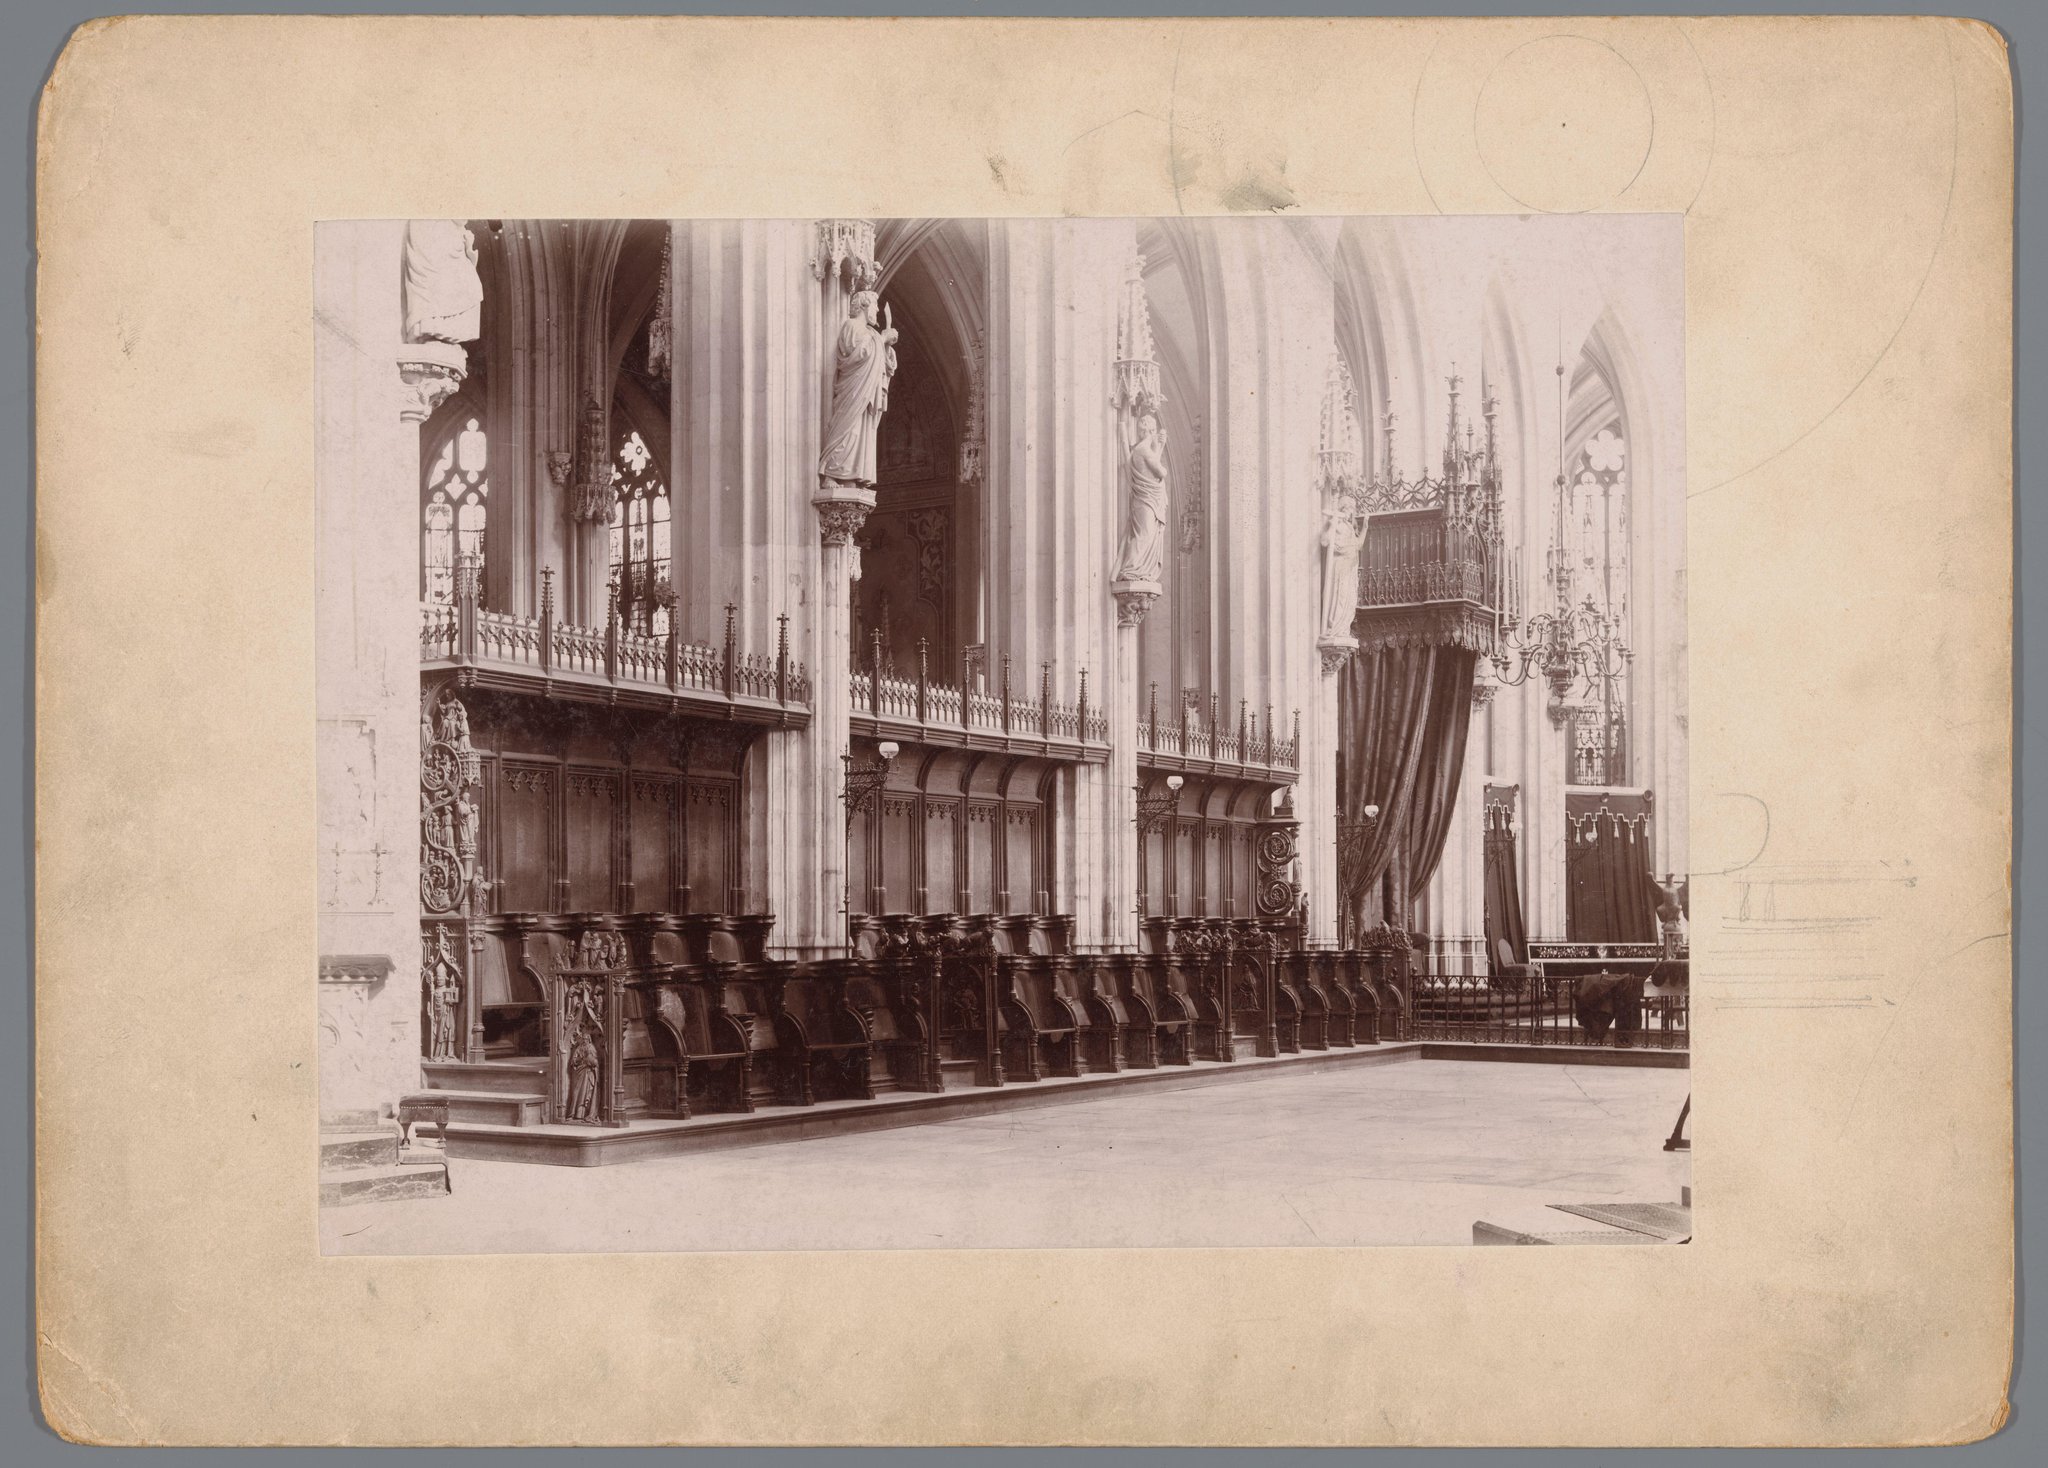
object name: photograph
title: Gezicht op de koorbanken van de Sint-Janskathedraal in 's-Hertogenbosch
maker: Anonymous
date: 1875-1900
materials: cardboard, photographic support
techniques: daylight paper print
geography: sint-janskathedraal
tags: interior of church, seats of the clergy, choir-stalls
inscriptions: collector's mark: Lugt 3937, annotation:, annotation:, annotation:, inscription: ‘s Janskerk te s Bosch gezicht op de Koorbanken links’